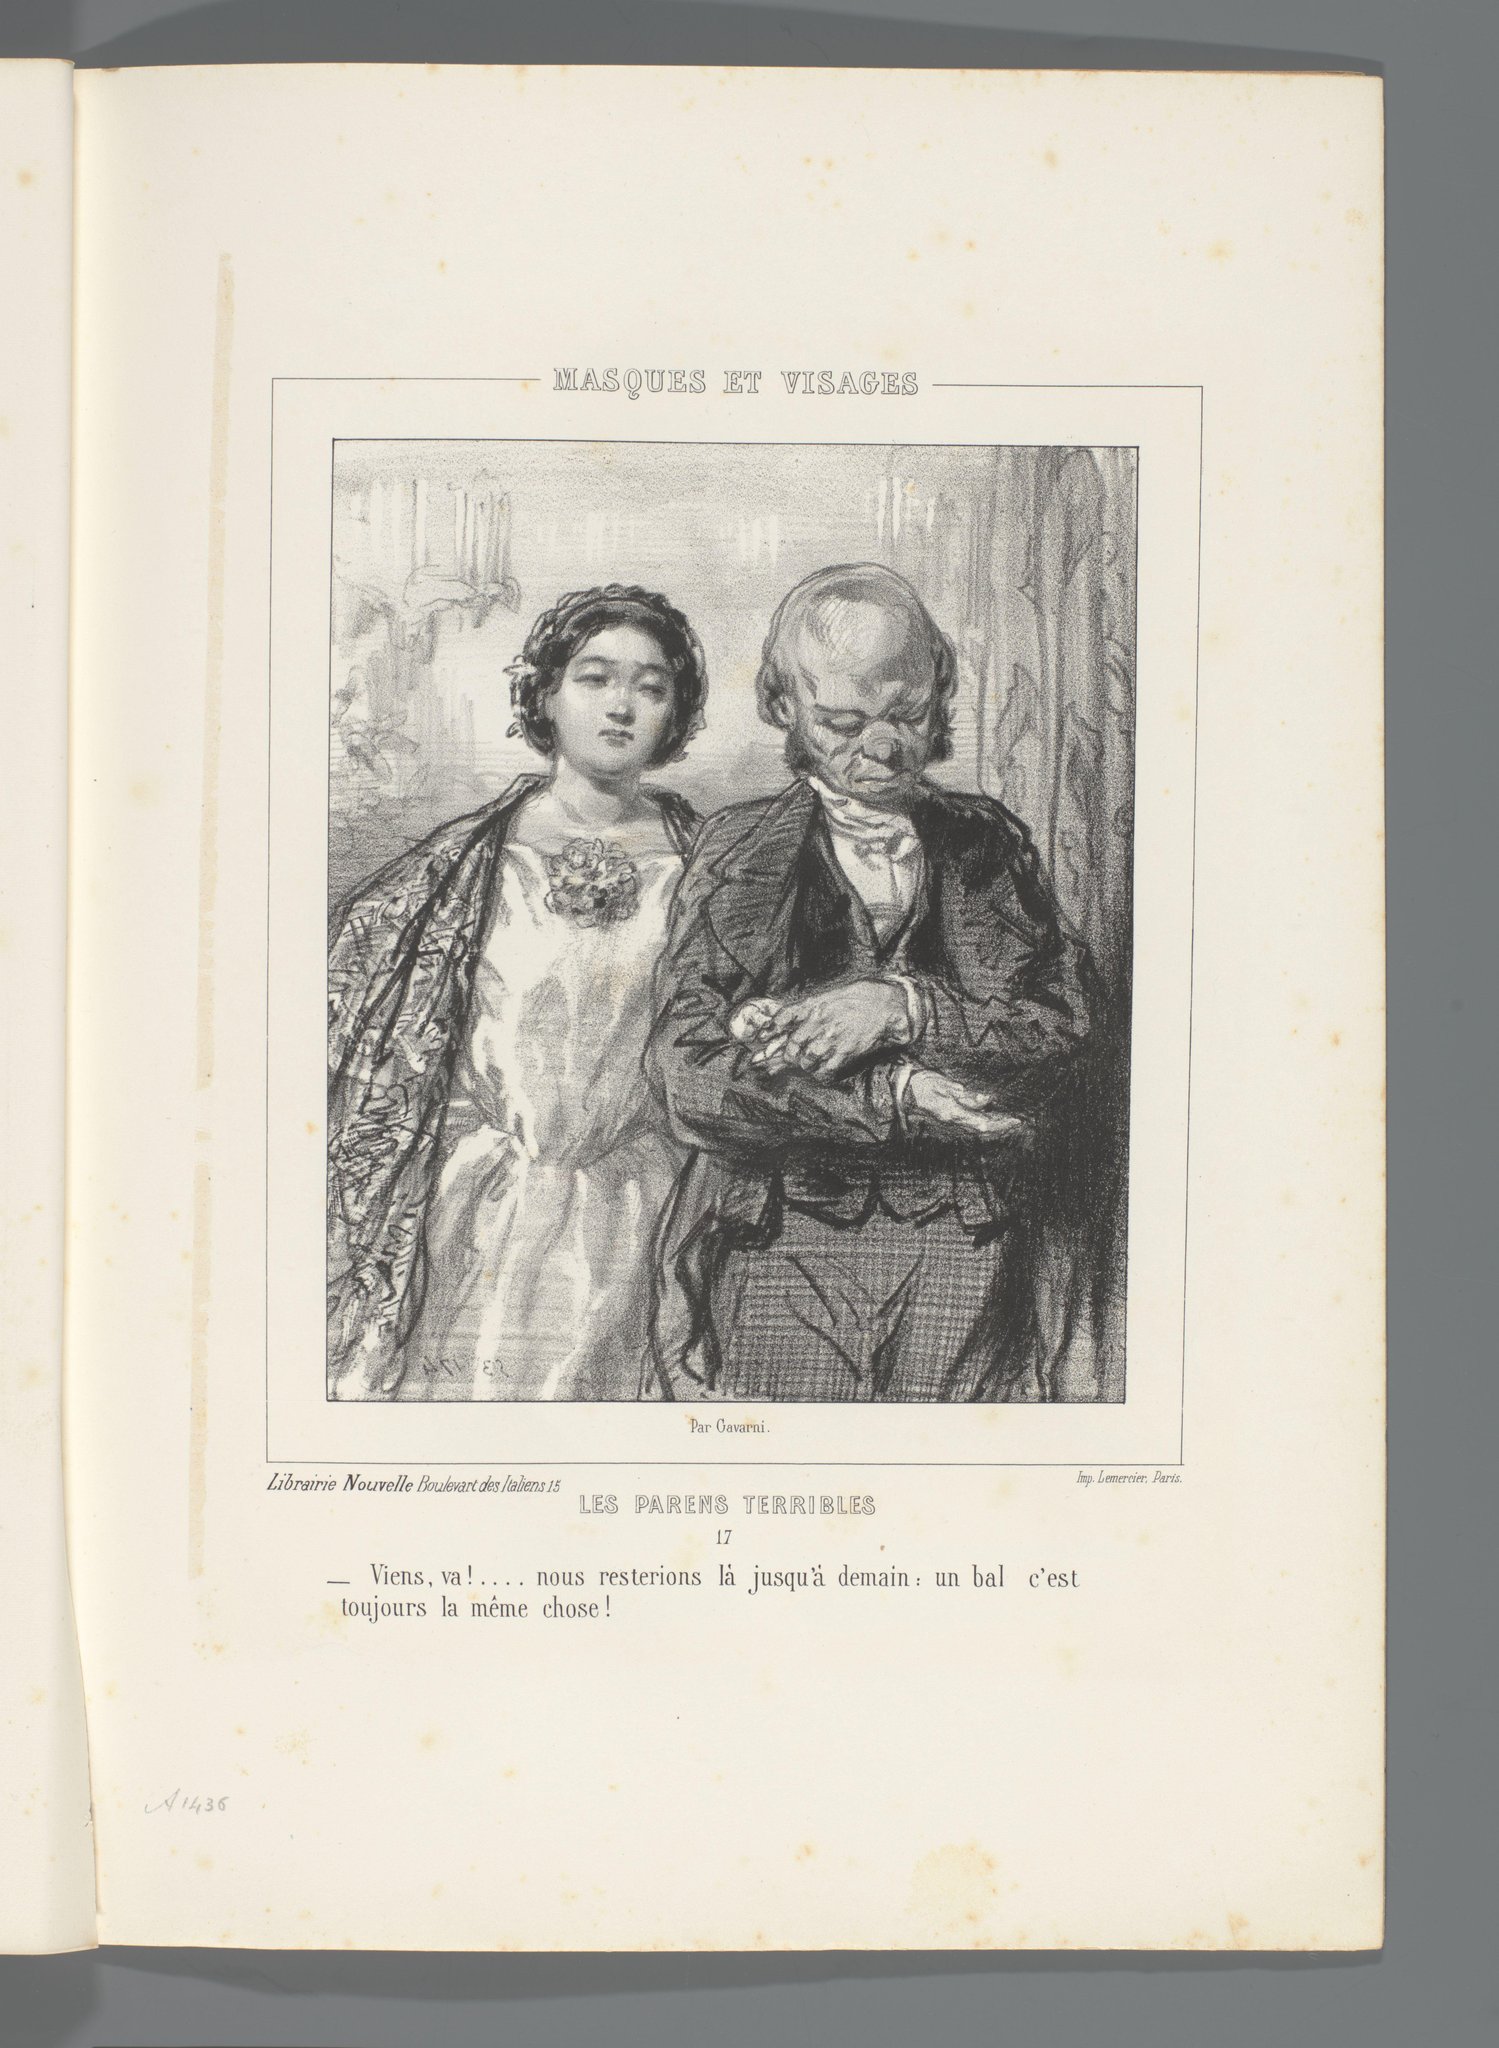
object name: cartoon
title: Vader besluit dat hij en zijn dochter het bal verlaten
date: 1853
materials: paper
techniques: lithograph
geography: paris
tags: adolescent, young woman, maiden, parents with their children, father and daughter(s) (family group) (with number of daughters)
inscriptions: collector's mark: Lugt 2228a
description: Prent gebruikt voor: Paris (Journal), december 1853.